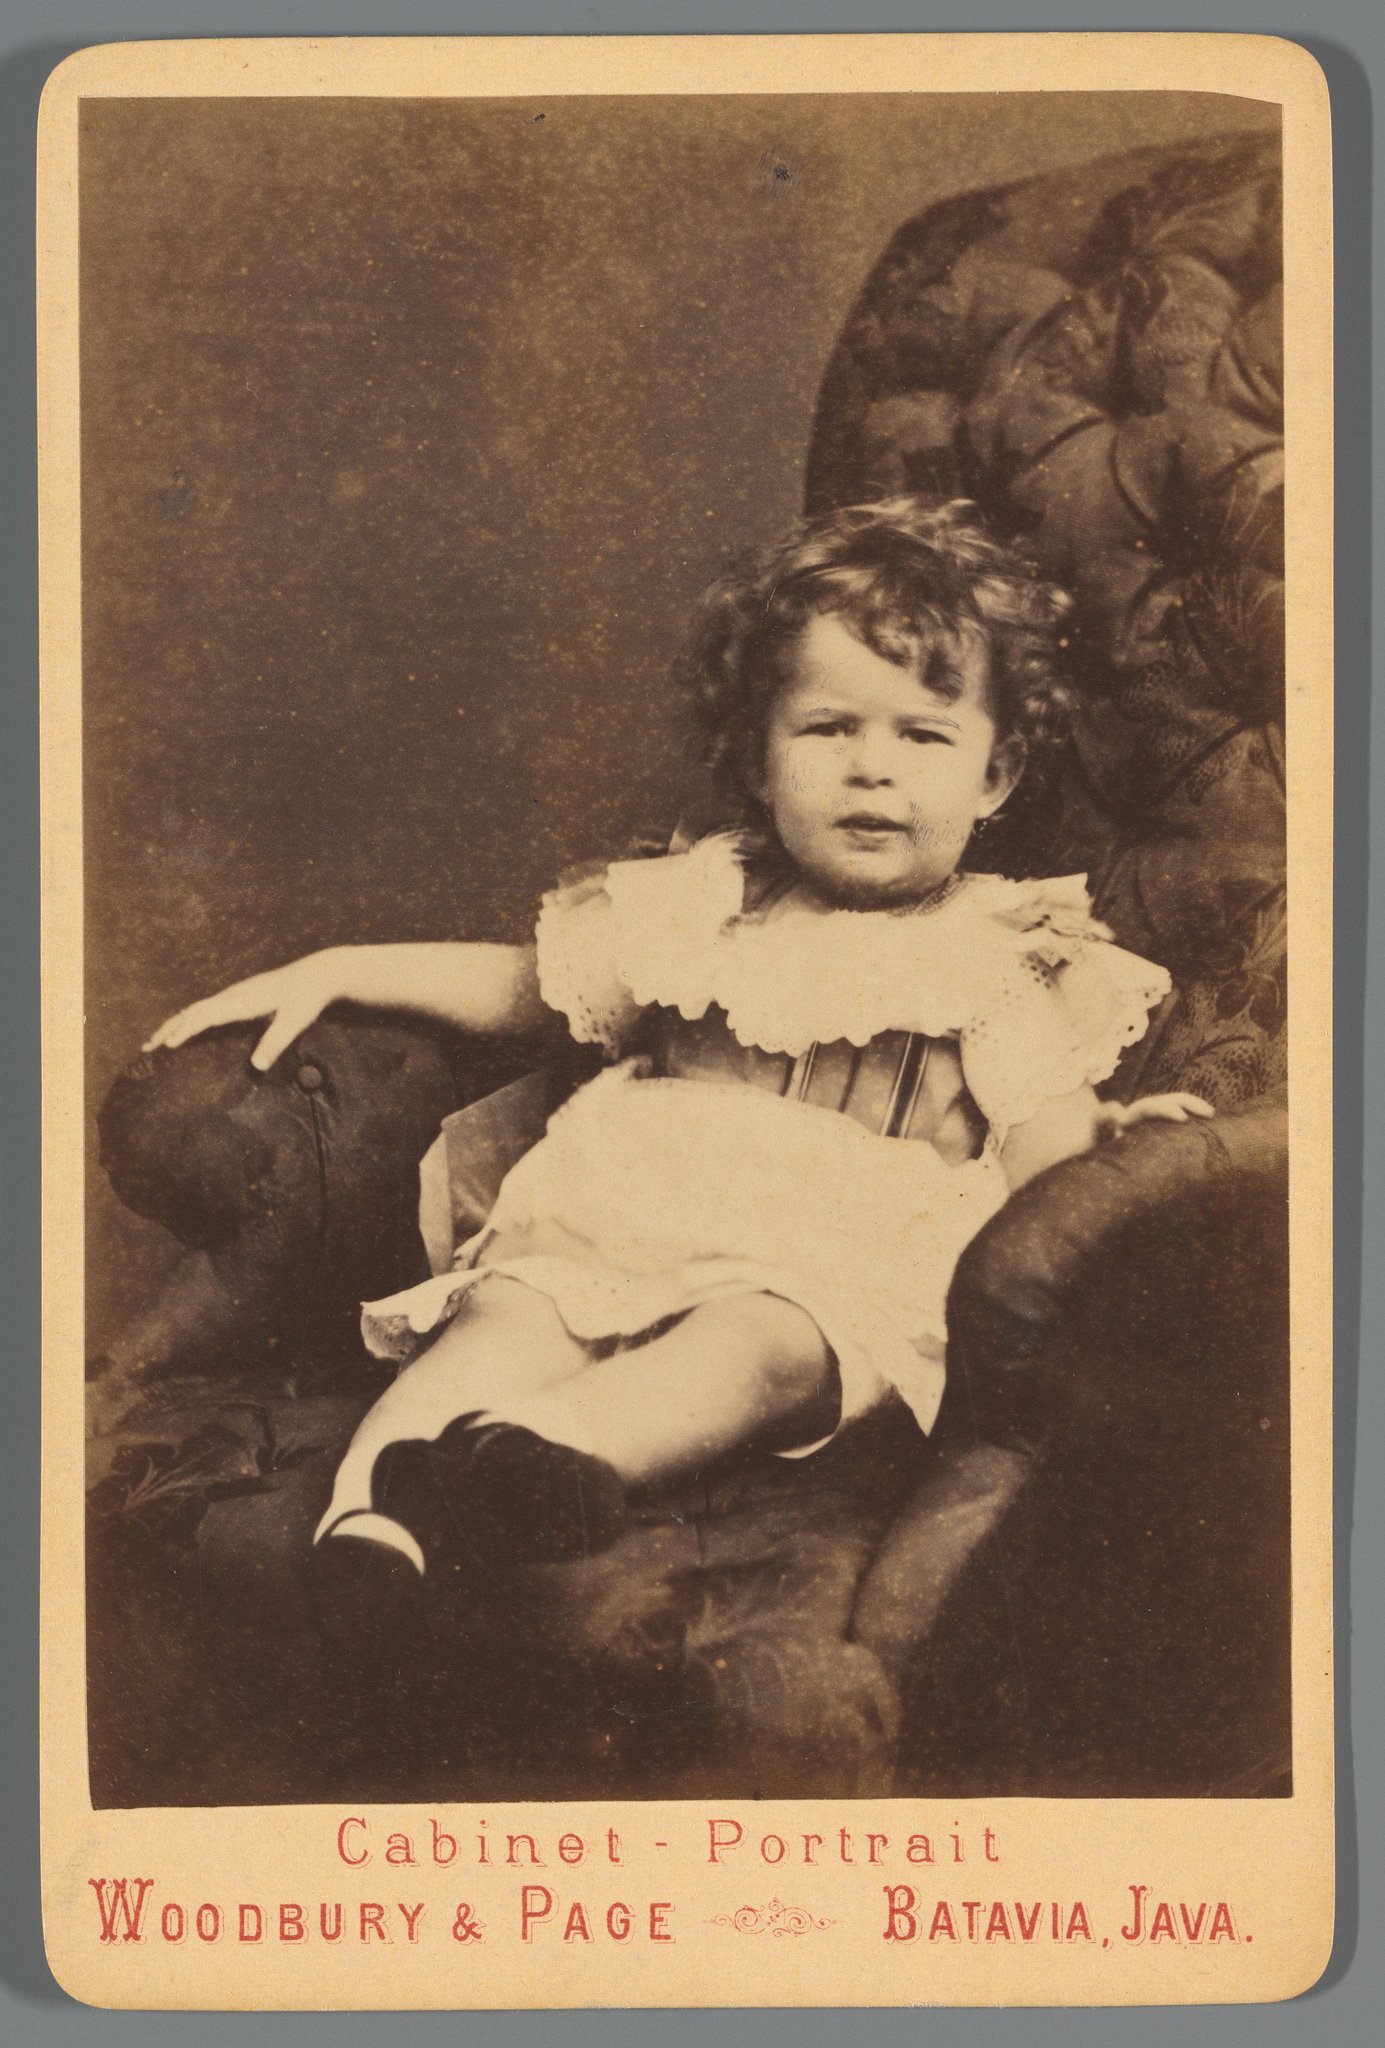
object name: cabinet photograph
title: Studioportret van Henriëtte van den Berg (Dé)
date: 1878-1880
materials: cardboard, photographic support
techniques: albumen print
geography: batavia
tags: henriëtte van den berg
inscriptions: name: ‘Cabinet - Portrait / WOODBURY & PAGE BATAVIA, JAVA.’, name: ‘WOODBURY & PAGE / Photographers / JAVA.’, name: ‘Henriëtte (Dé) van den Berg’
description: Studioportret van kind zittend in fauteuil.